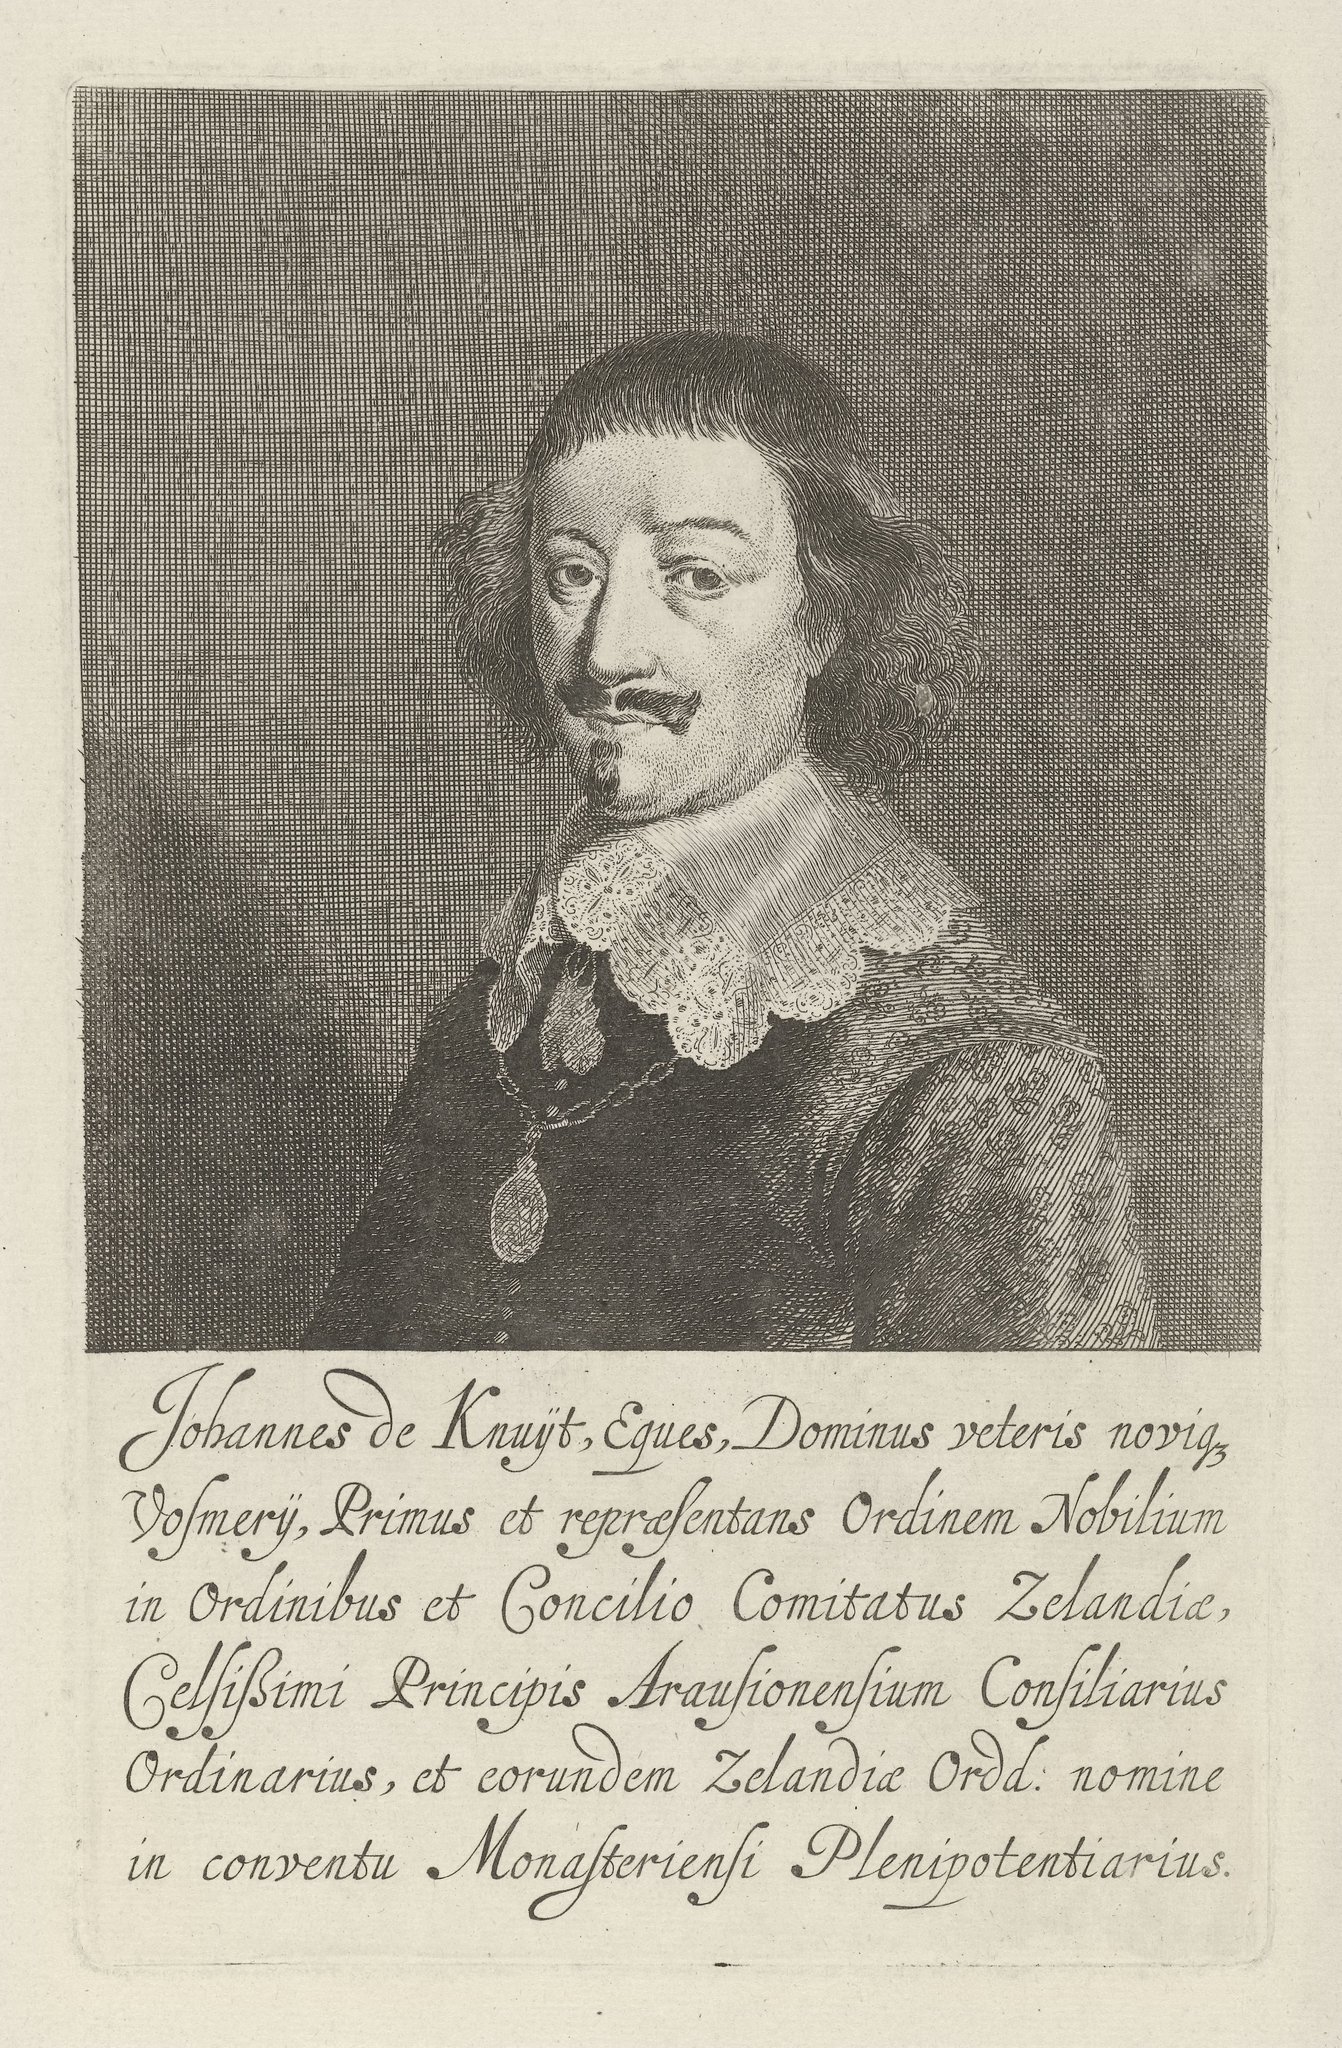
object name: print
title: Portret van Johan de Knuyt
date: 1644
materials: paper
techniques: engraving, etching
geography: amsterdam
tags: johan de knuyt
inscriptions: collector's mark: Lugt 2228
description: Portret van Johan de Knuyt, gekleed in een jas met een kanten kraag. Aan een ketting om zijn hals hangt een hanger. Buste naar links. Onderaan in de marge een zesregelige tekst in het Latijn.